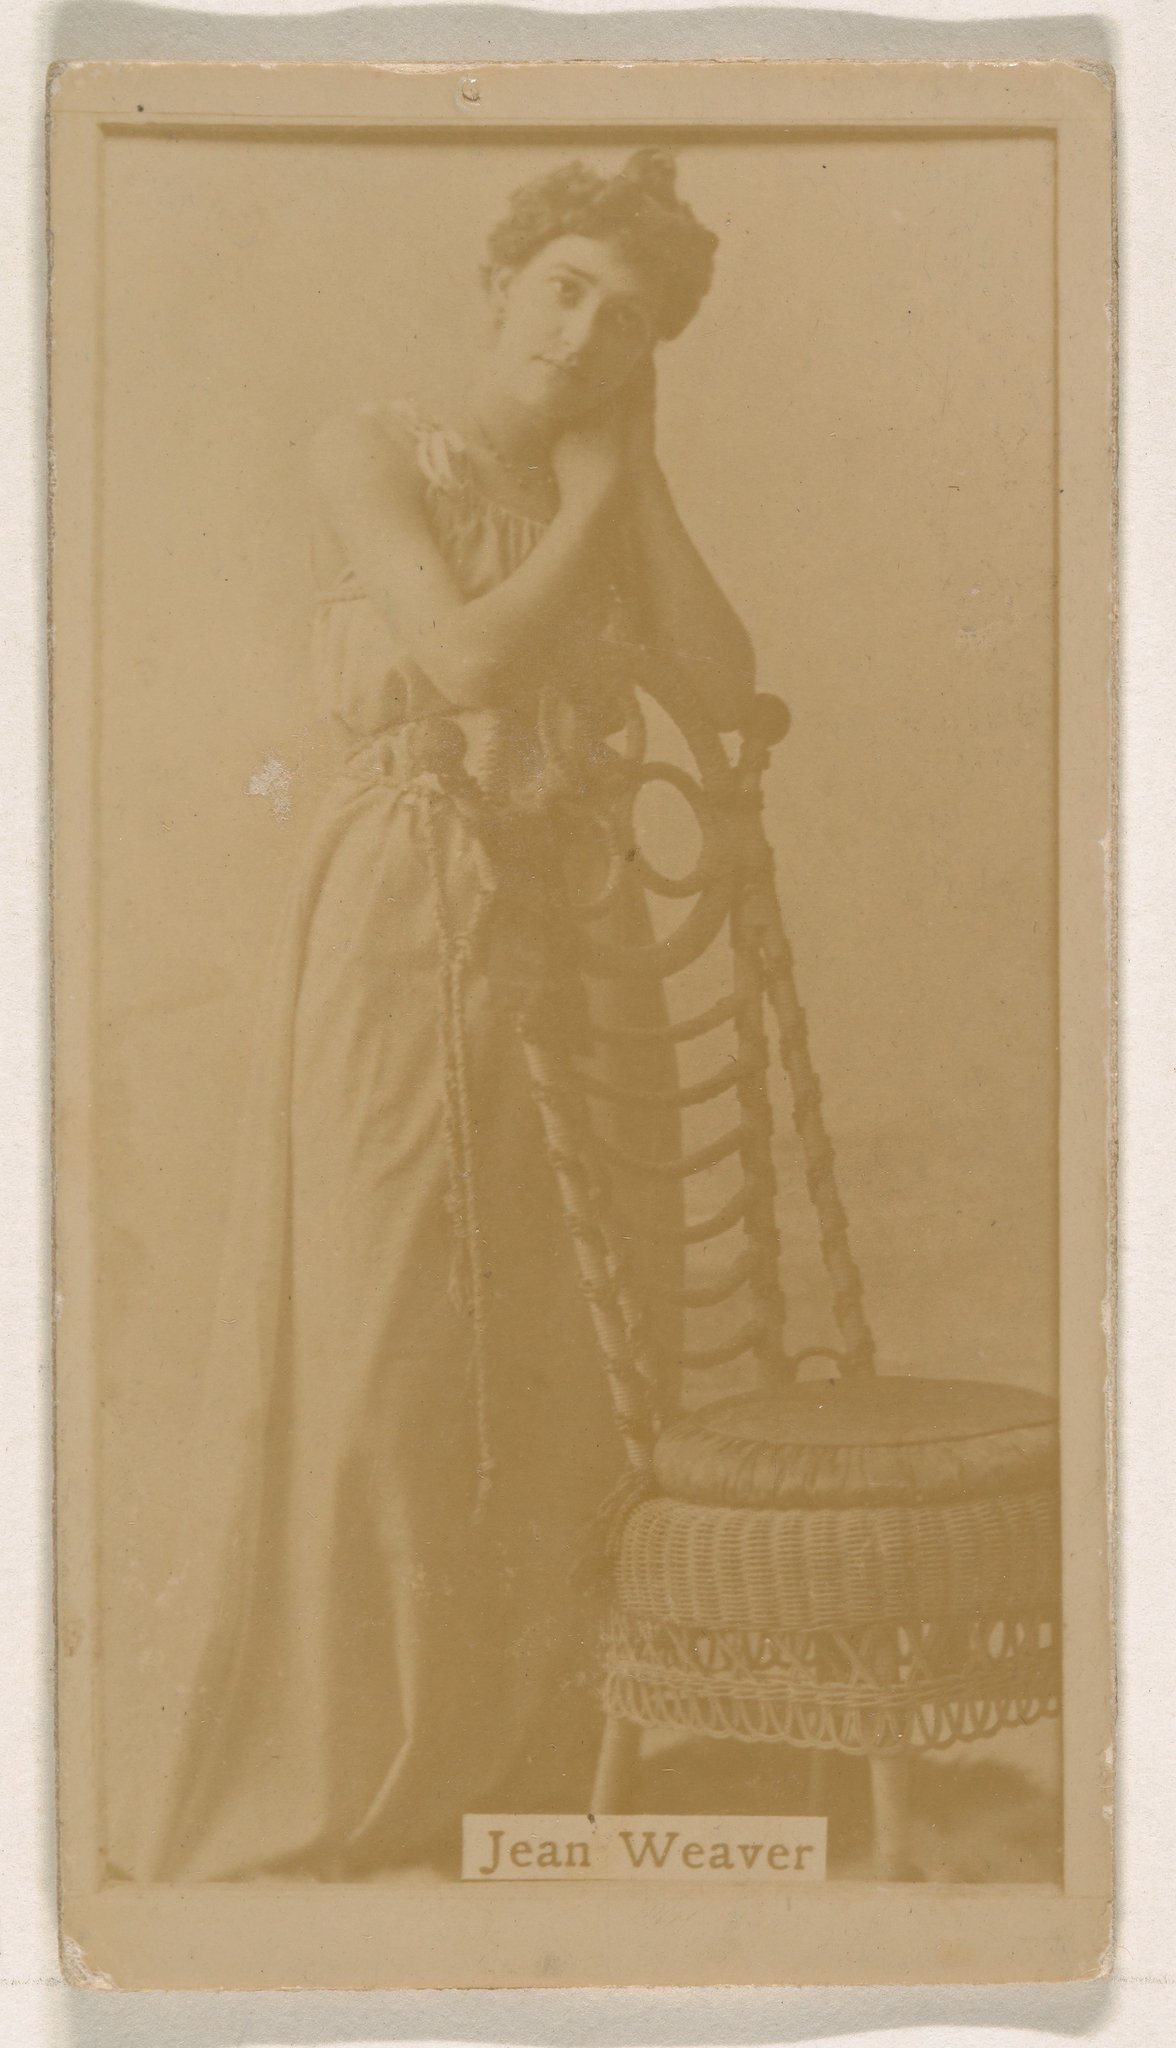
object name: photograph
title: Jean Weaver, from the Actresses series (N245) issued by Kinney Brothers to promote Sweet Caporal Cigarettes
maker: kinney brothers tobacco company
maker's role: publisher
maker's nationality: american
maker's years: 1869-2011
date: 1890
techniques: albumen silver print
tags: portraits,women,actresses